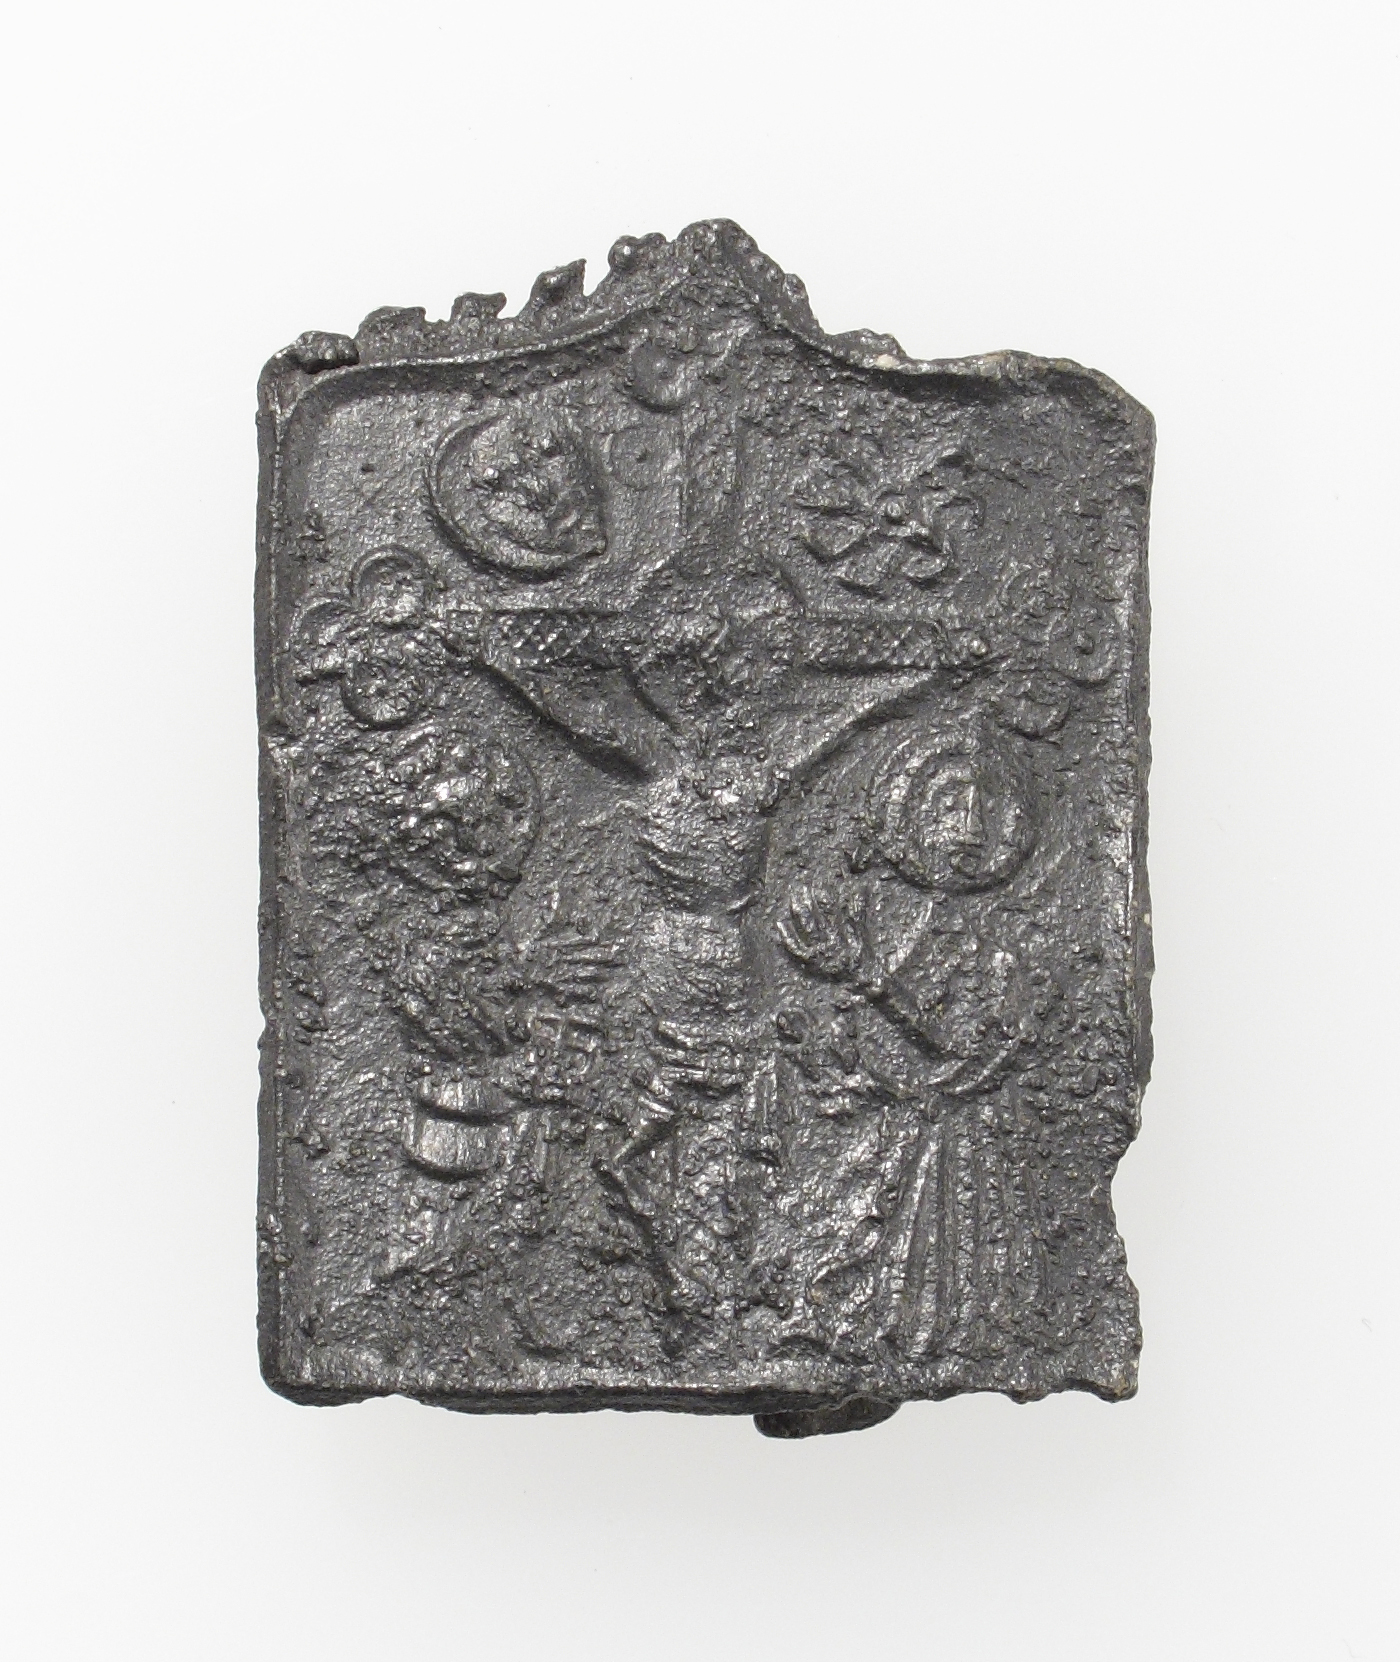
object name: pilgrim's badge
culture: french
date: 1301-1600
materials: lead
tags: christ,crucifixion